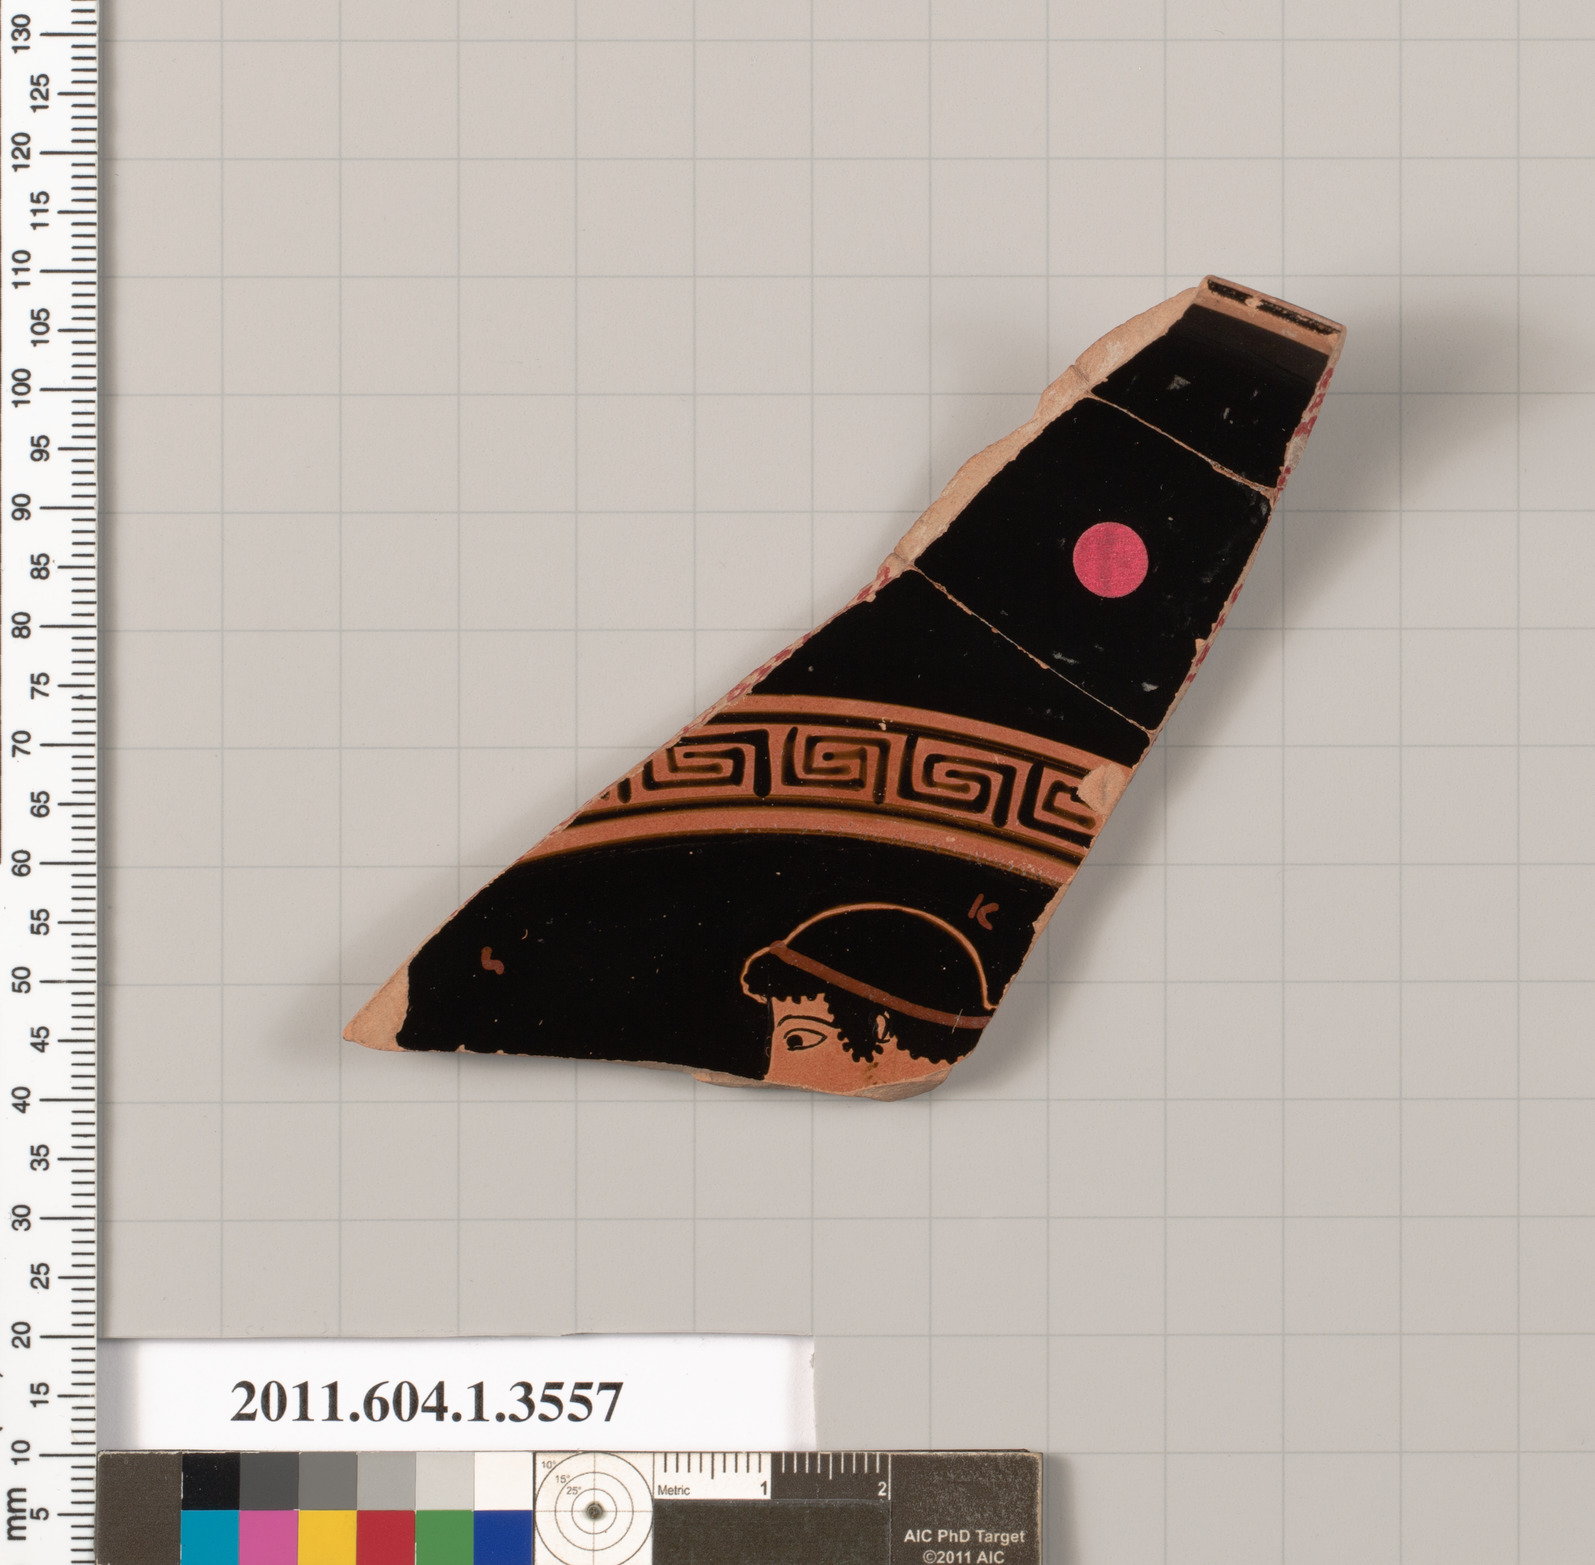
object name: kylix fragment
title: Terracotta rim fragment of a kylix (drinking cup)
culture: greek, attic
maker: tarquinia painter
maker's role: artist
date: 470-460 BCE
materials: terracotta